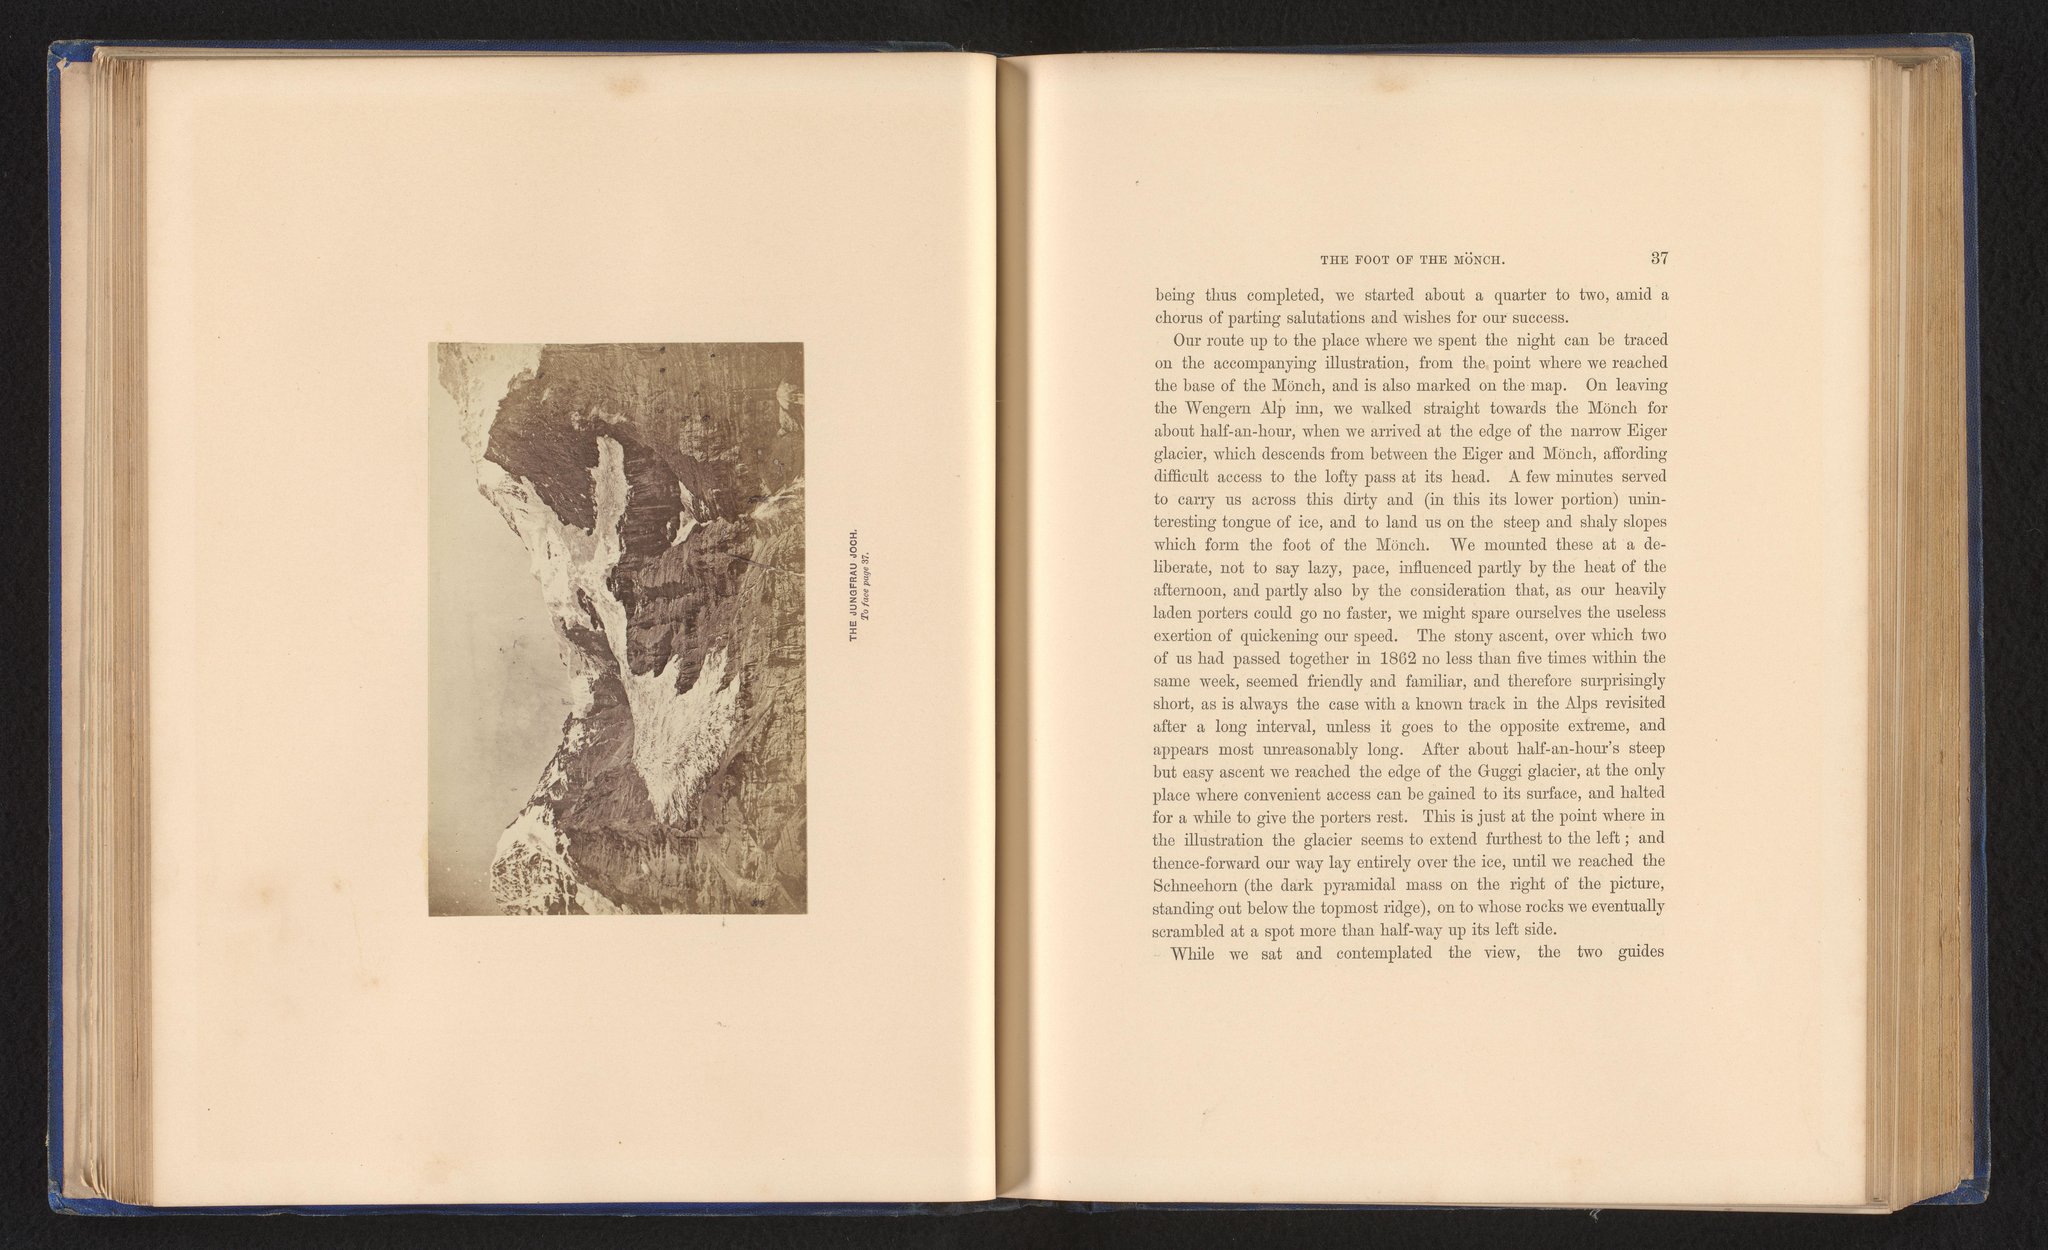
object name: page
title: Gezicht op de Jungfraujoch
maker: ernest edwards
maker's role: fotograaf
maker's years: 1837-1903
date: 1861-1866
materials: paper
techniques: albumen print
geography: berner alpen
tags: mountains